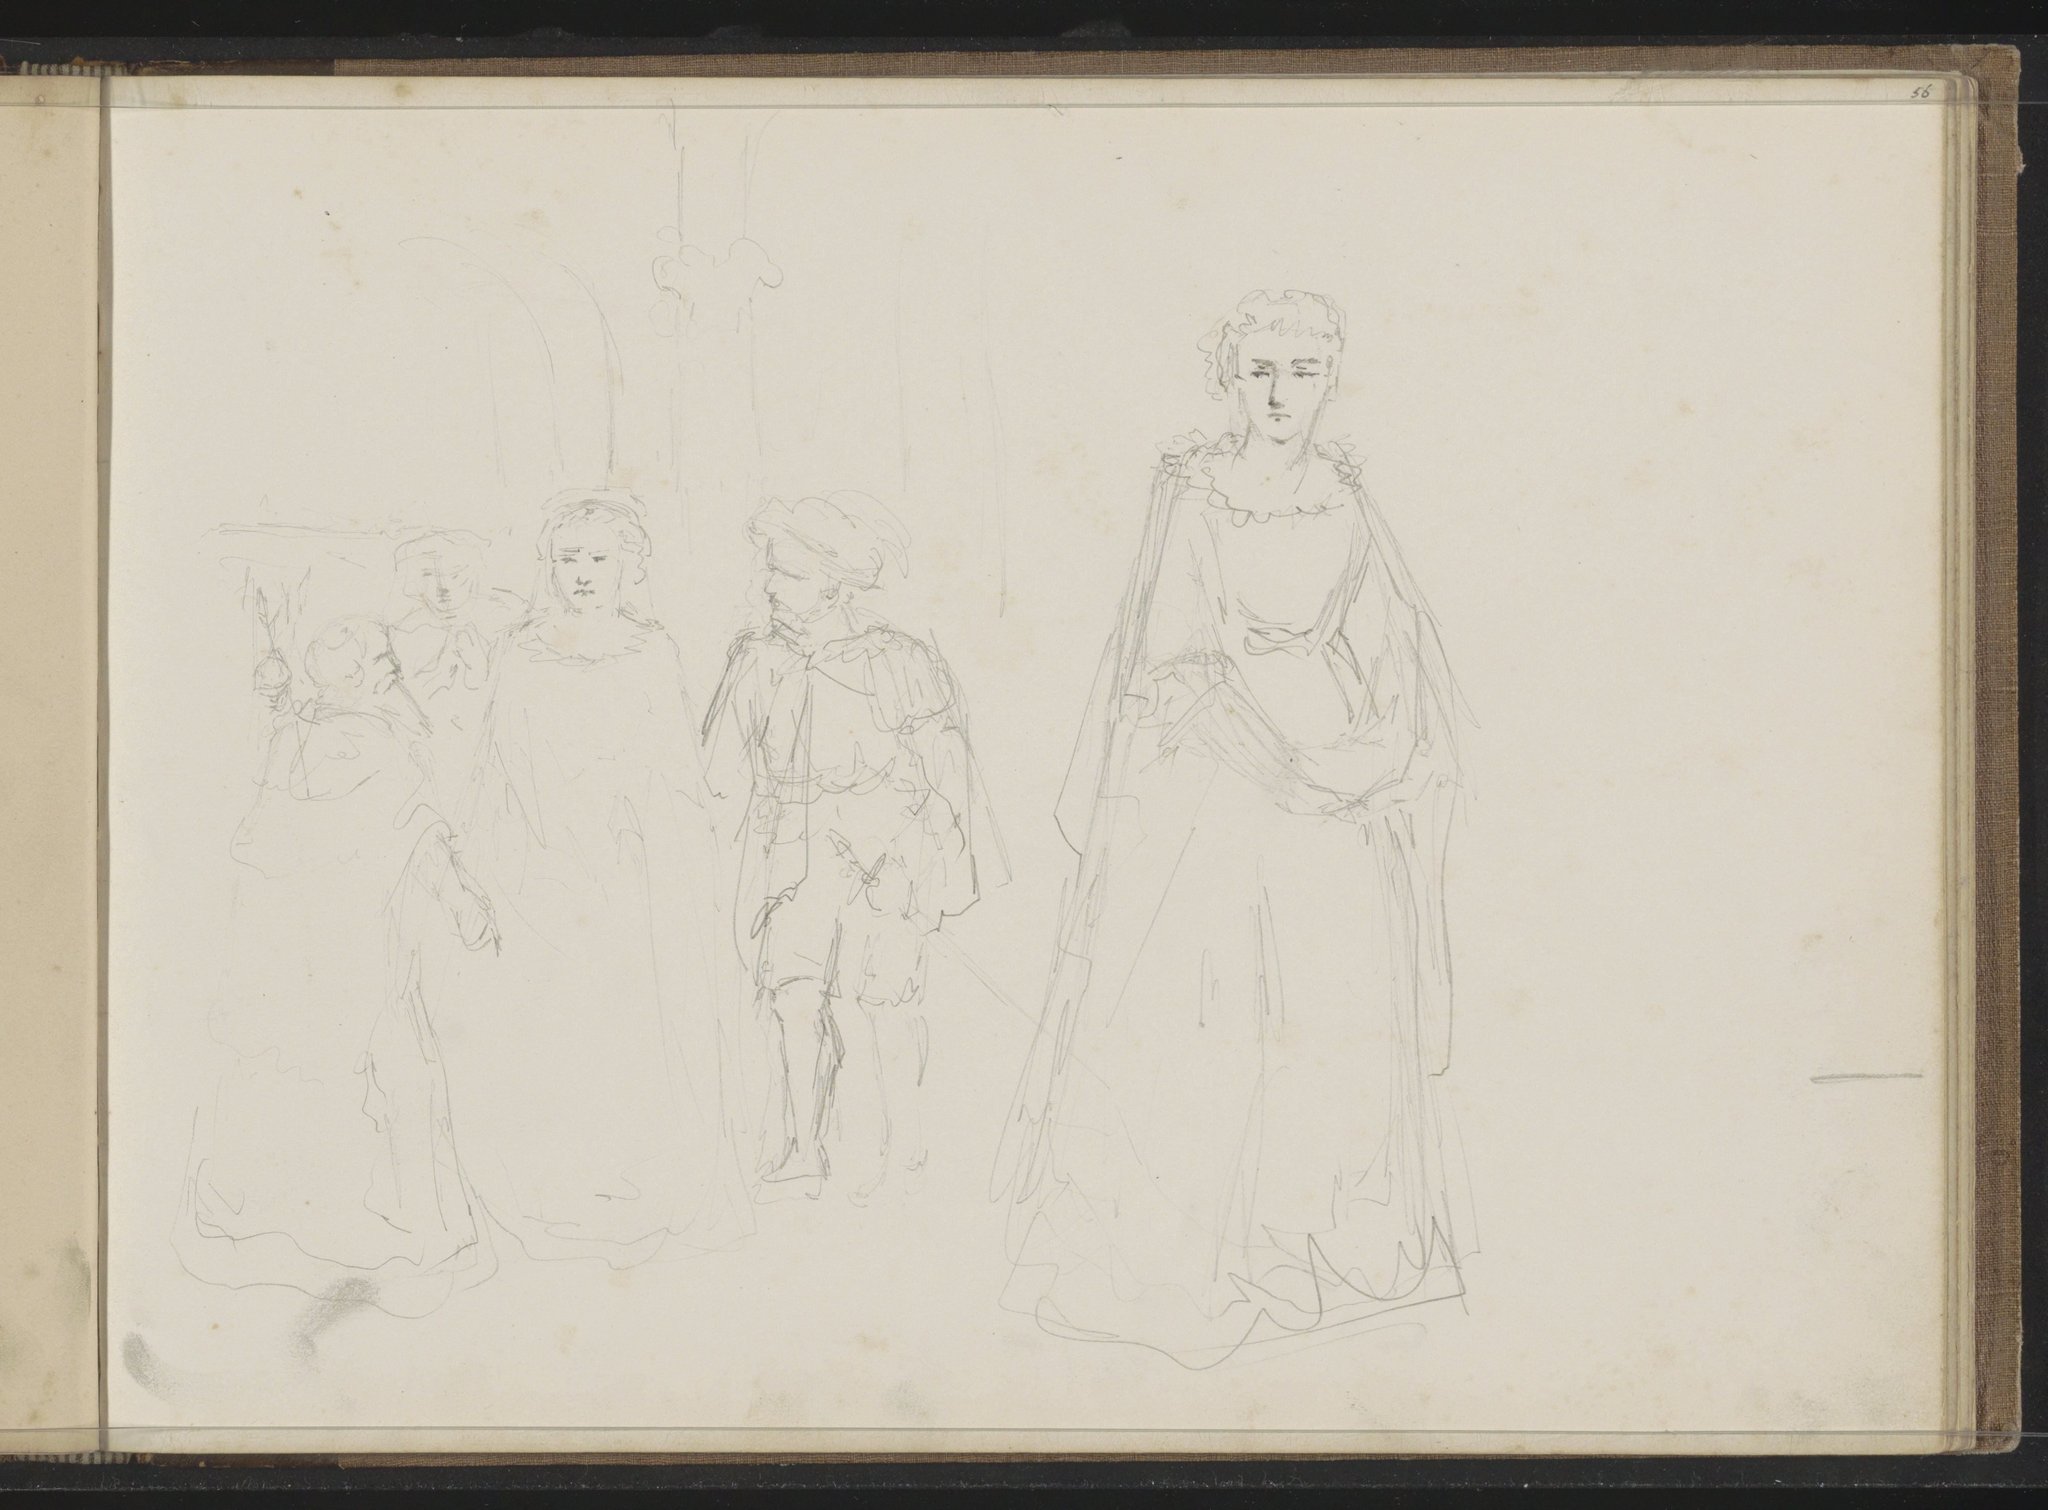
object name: sketchbook leaf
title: Paar, mogelijk een bruidspaar, in een interieur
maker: hendrik valkenburg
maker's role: draughtsman, painter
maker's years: 1826-1896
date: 1805-1862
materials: paper, pencil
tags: clothes for special purposes, couple of lovers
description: De vrouw draagt een lange jurk en de man een een kniebroek, mantel en tulband. Het paar wordt begeleid door een man met een baard en een jongen. Op de achtergrond een zuil en doorgang. Blad 56 recto uit een schetsboek met 77 bladen.